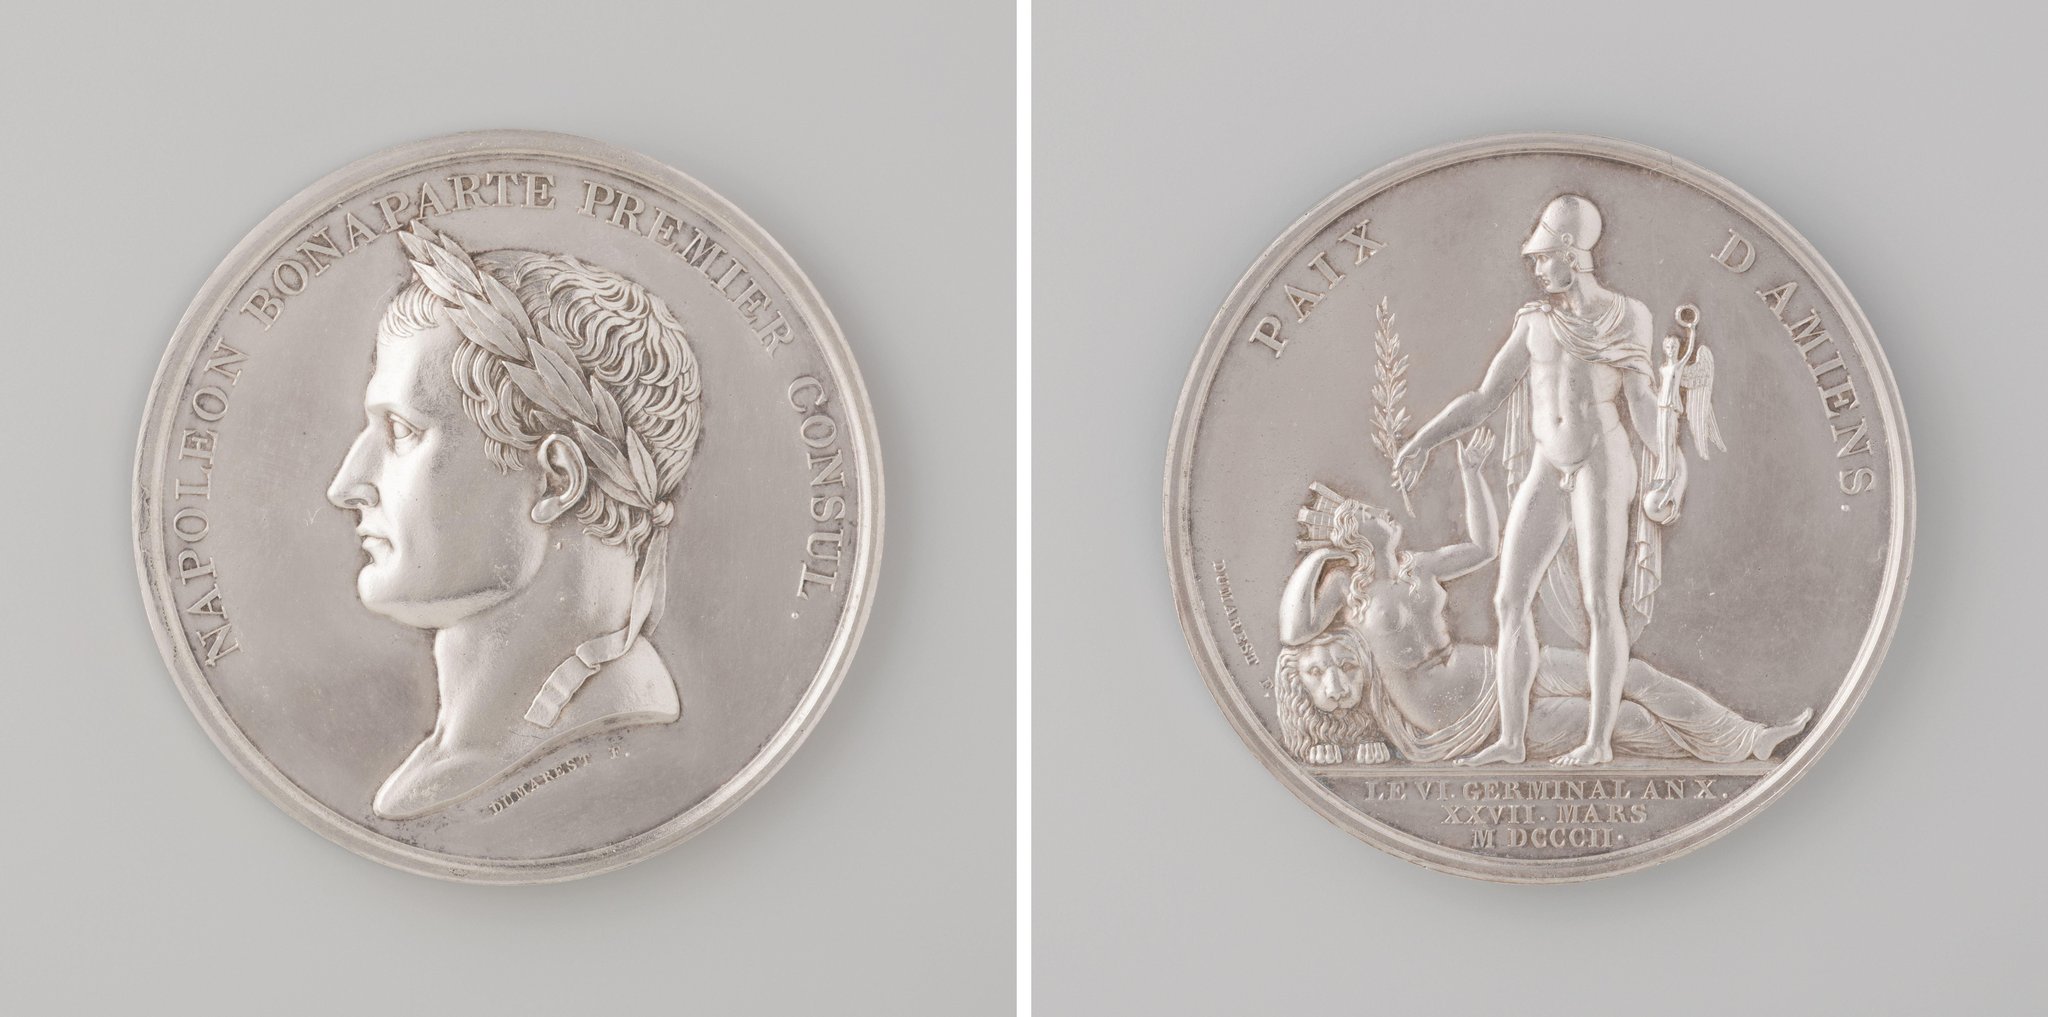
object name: history medal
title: Vrede van Amiens, ter ere van Napoleon Bonaparte, premier consul van Frankrijk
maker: rambert dumarest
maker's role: medailleur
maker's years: 1750-1806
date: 1802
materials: silver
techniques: striking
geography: paris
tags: napoleon i (emperor of the french)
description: Zilveren penning. Voorzijde: borststuk man met lauwerkrans binnen omschrift. Keerzijde: gehelmde Mars, voostellende Napoleon Bonaparte, houdt in linkerhand beeldje van gevleugelde Overwinning en reikt met andere hand olijftak aan gekroonde vrouw, die tegen leeuwenkop rust binnen omschrift; afsnede: opschrift